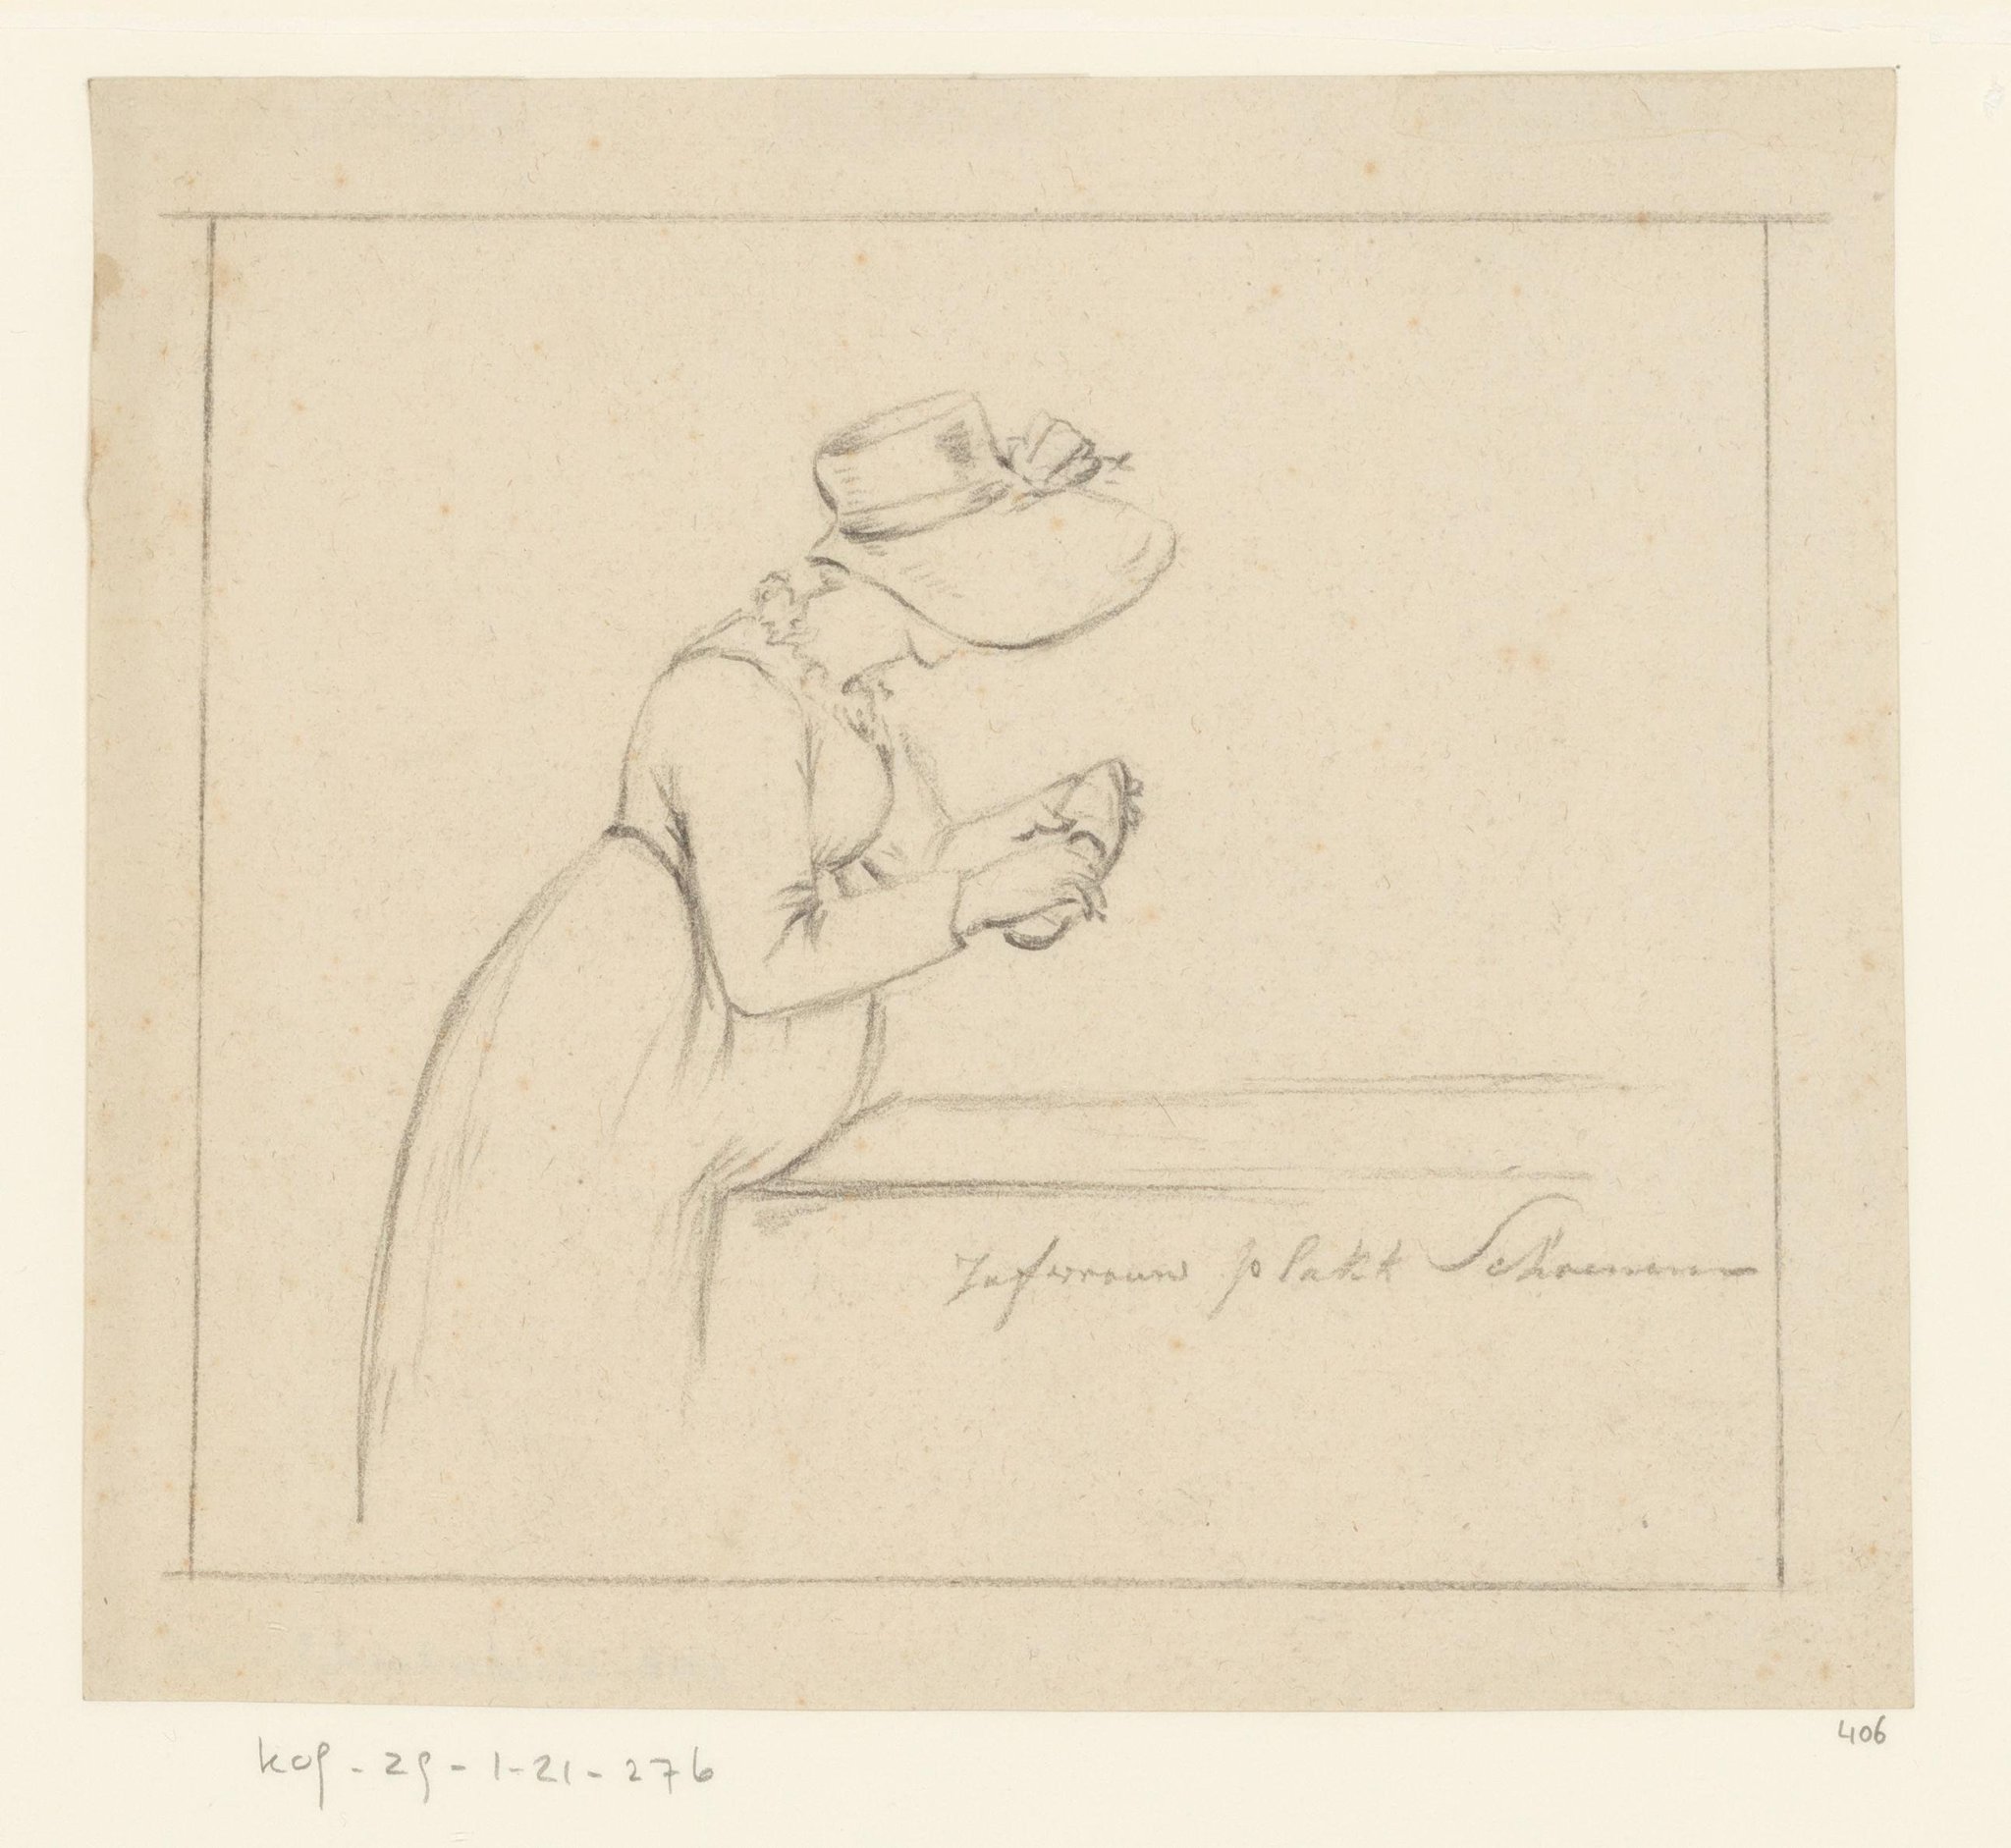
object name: drawing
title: Juffrouw plakt schoenen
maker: jean bernard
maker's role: draughtsman, print maker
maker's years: 1765-1833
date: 1775-1833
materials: chalk, paper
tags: adult woman, head-gear: cap, shoe-maker, cobbler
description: Onderwerpsrubrieken binnen de Atlas Zeden en Gewoonten: Zeden en Gewoonten in Engeren Zin, De Kleeding, Kleederdrachten (tijdvakken), De regeering van Willem I. Mannen en vrouwen.